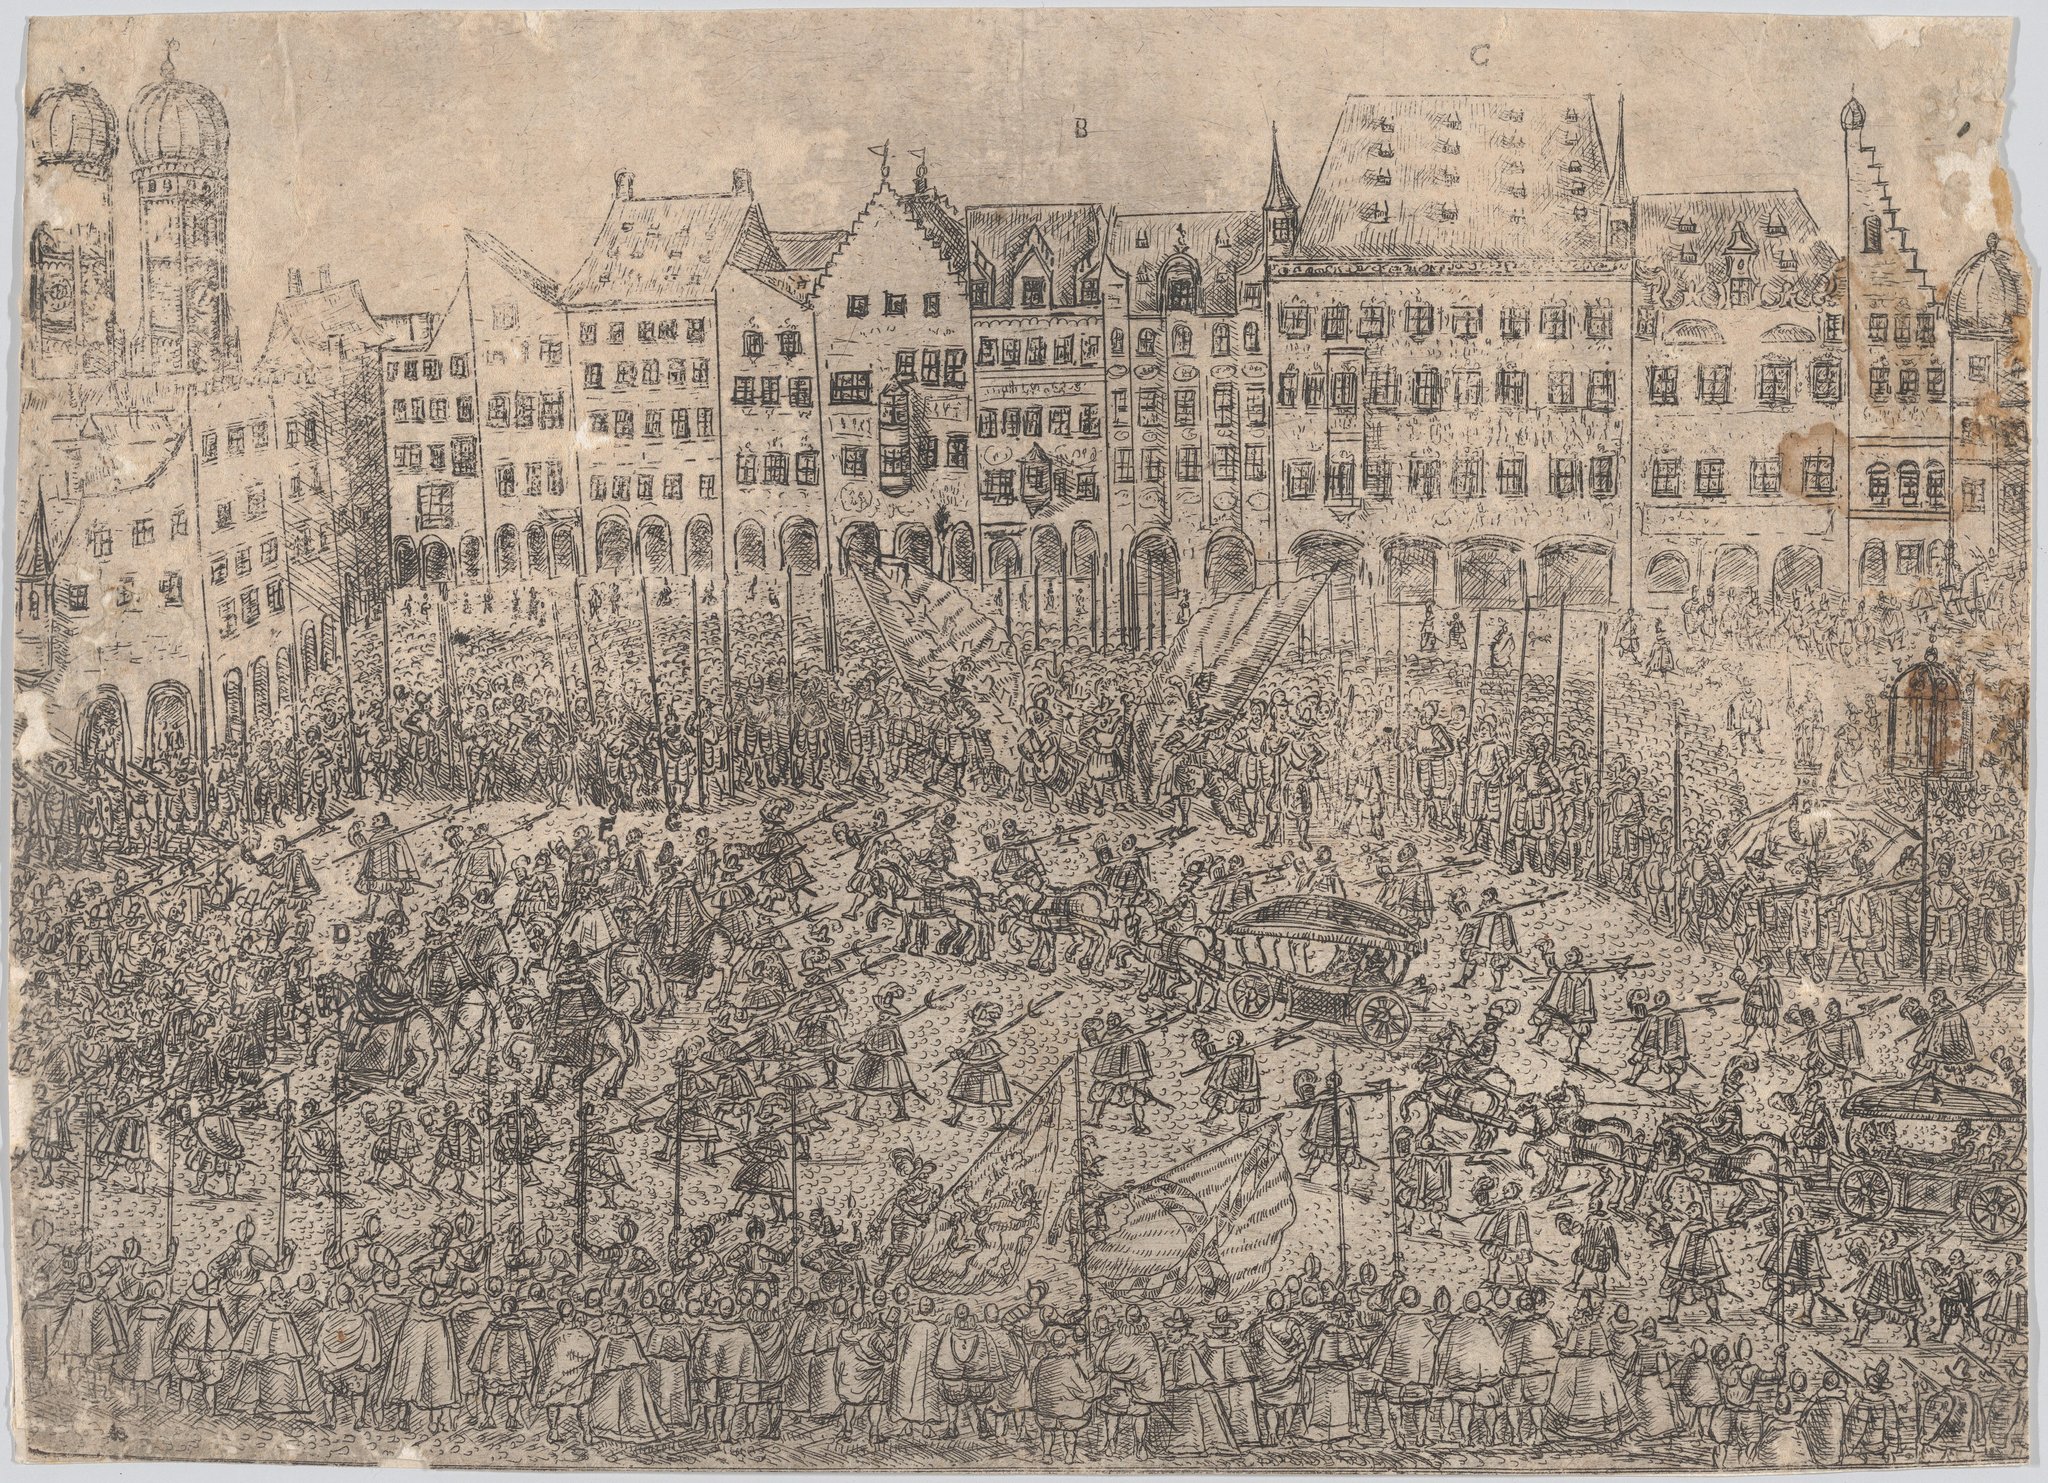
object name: print, fete, ornament architecture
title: How one entered the church (Folgt wie man zur Kirchen gangen), from a series depicting the wedding of Wolfgang Wilhelm, Duke of Pfalz-Neuberg, Pfalzgraf, and Magdalena, Duchess of Bavaria, in Munich, 1613 (Plate 4)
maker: wilhelm peter zimmermann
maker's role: publisher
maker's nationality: german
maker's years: 1589-1635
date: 1614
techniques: etching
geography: augsburg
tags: crowd